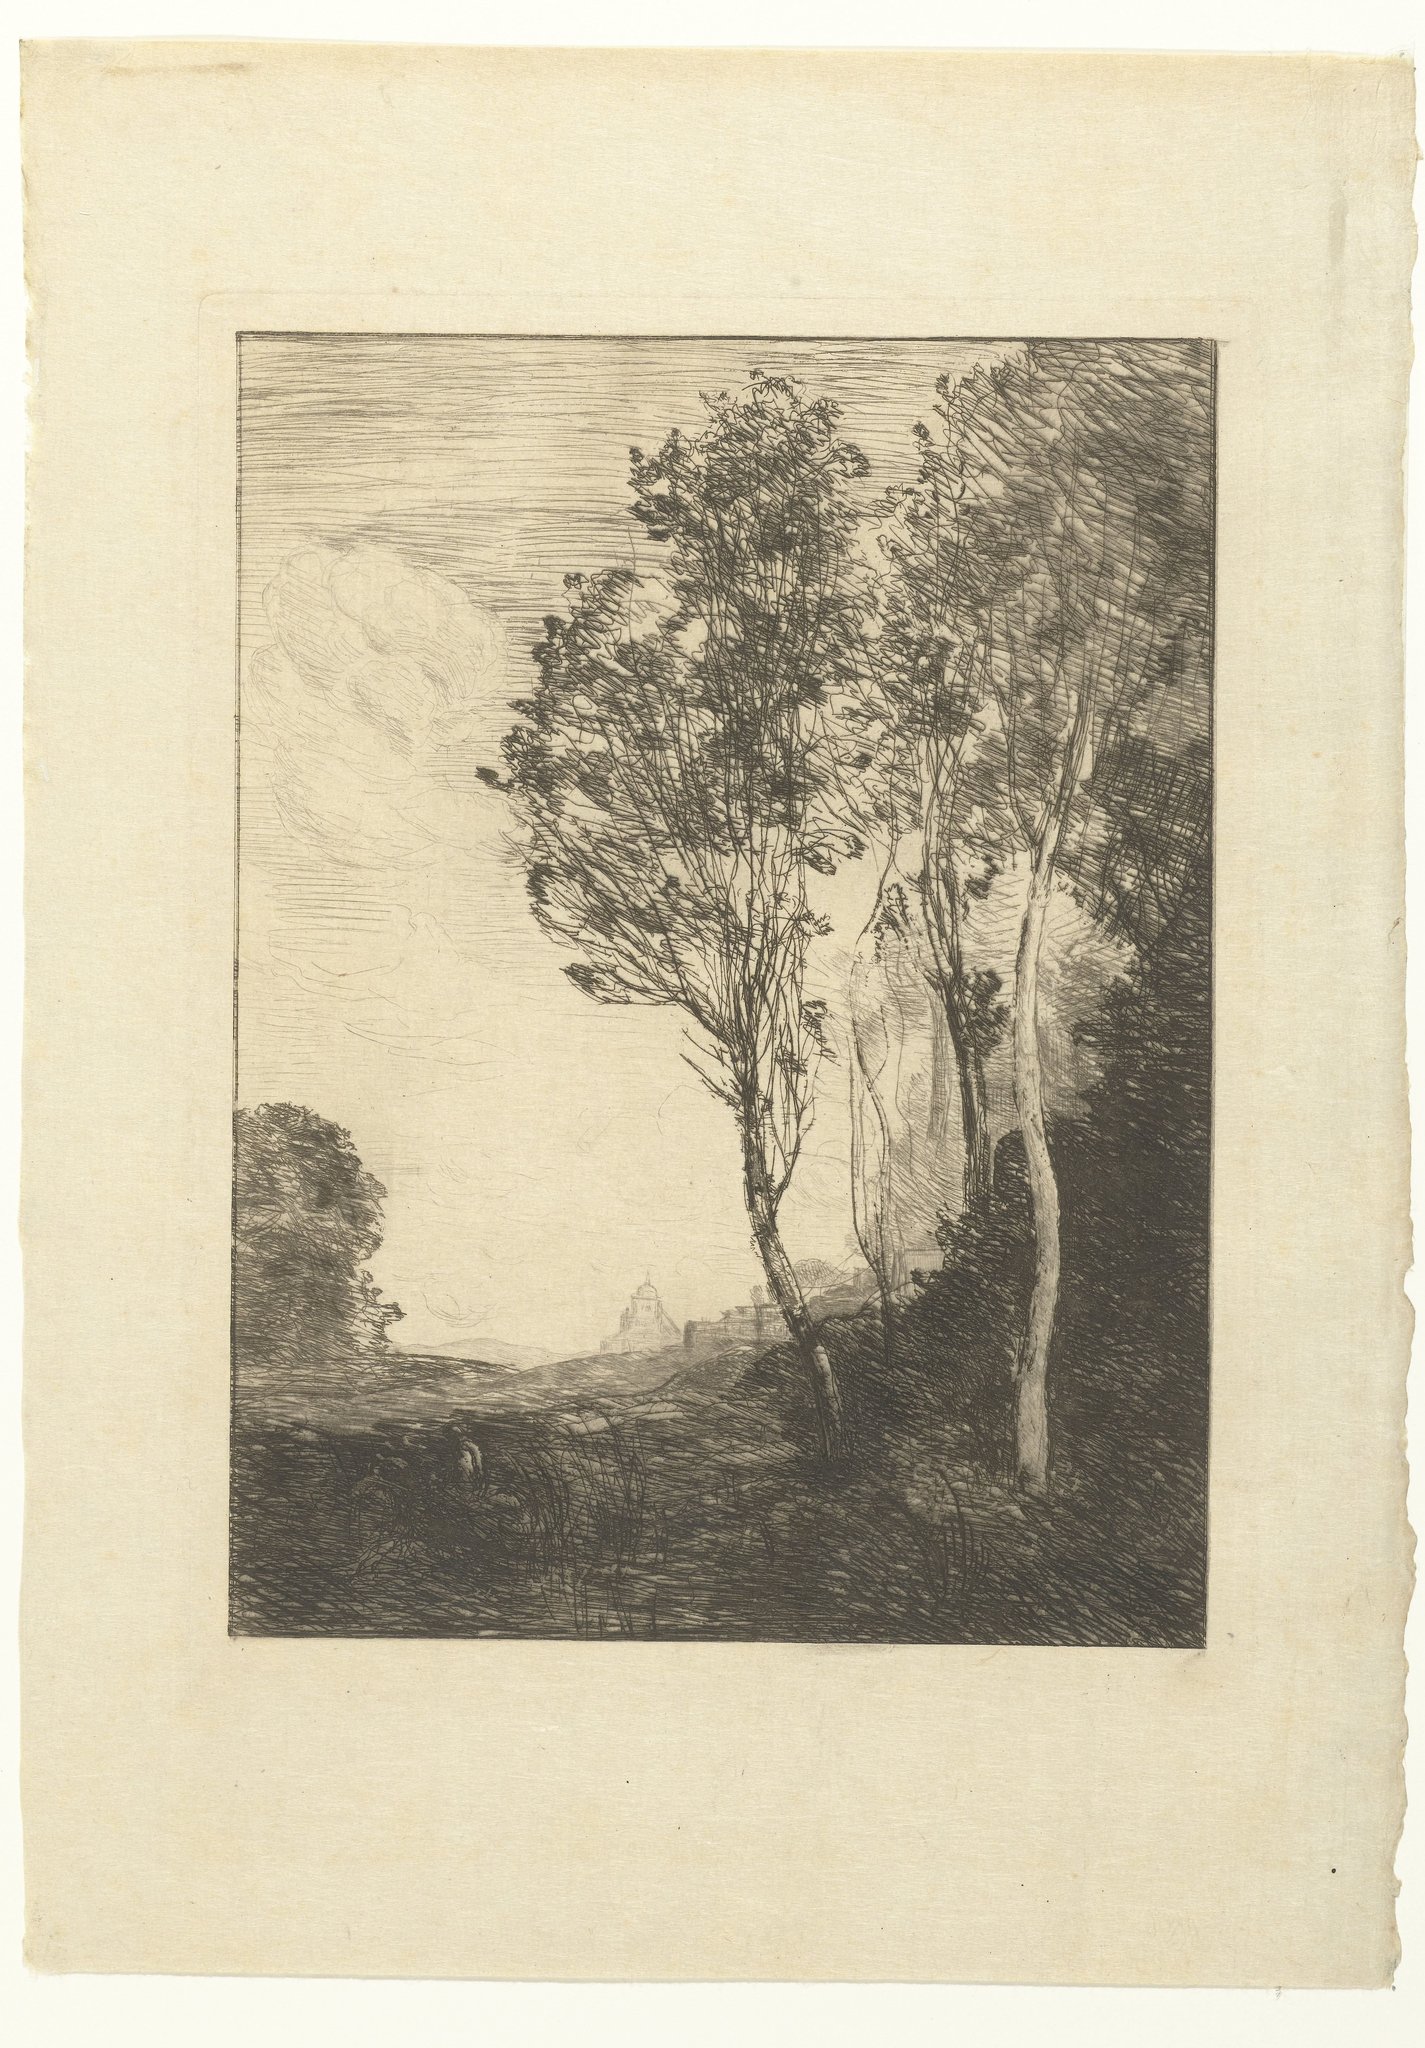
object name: print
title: Italiaans landschap met bomen en kerk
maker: camille corot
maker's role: draughtsman, painter, print maker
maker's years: 1796-1875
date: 1865-1866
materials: paper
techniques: etching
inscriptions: collector's mark: Lugt 2228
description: Late druk uit de collectie van Storm van 's Gravesande w.s. van Goulding